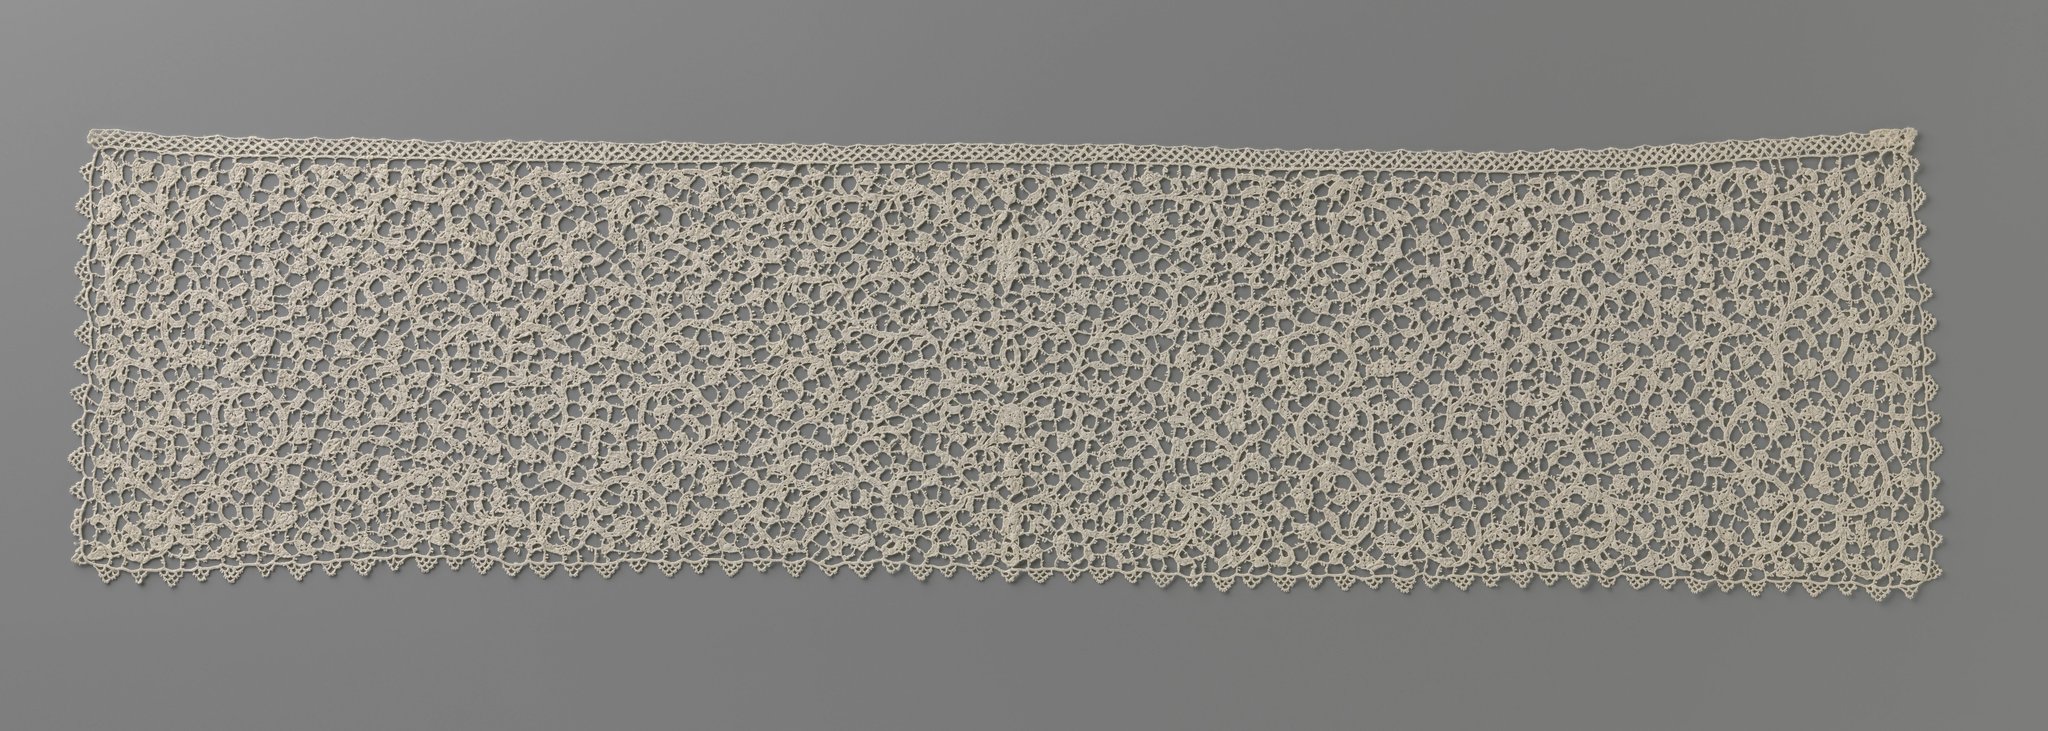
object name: jabot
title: Jabot van naaldkant met serpentines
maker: Anonymous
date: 1675-1699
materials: linen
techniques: flat venetian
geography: venice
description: Jabot van naturelkleurige naaldkant: platte Venetiaanse kant. Op een spijlengrond staan spiraalranken met kleine knopvormige uiteinden symmetrisch ten opzichte van een staande middenas. In de rechte hoeken staat een groep met grote en kleinere driehoekjes.